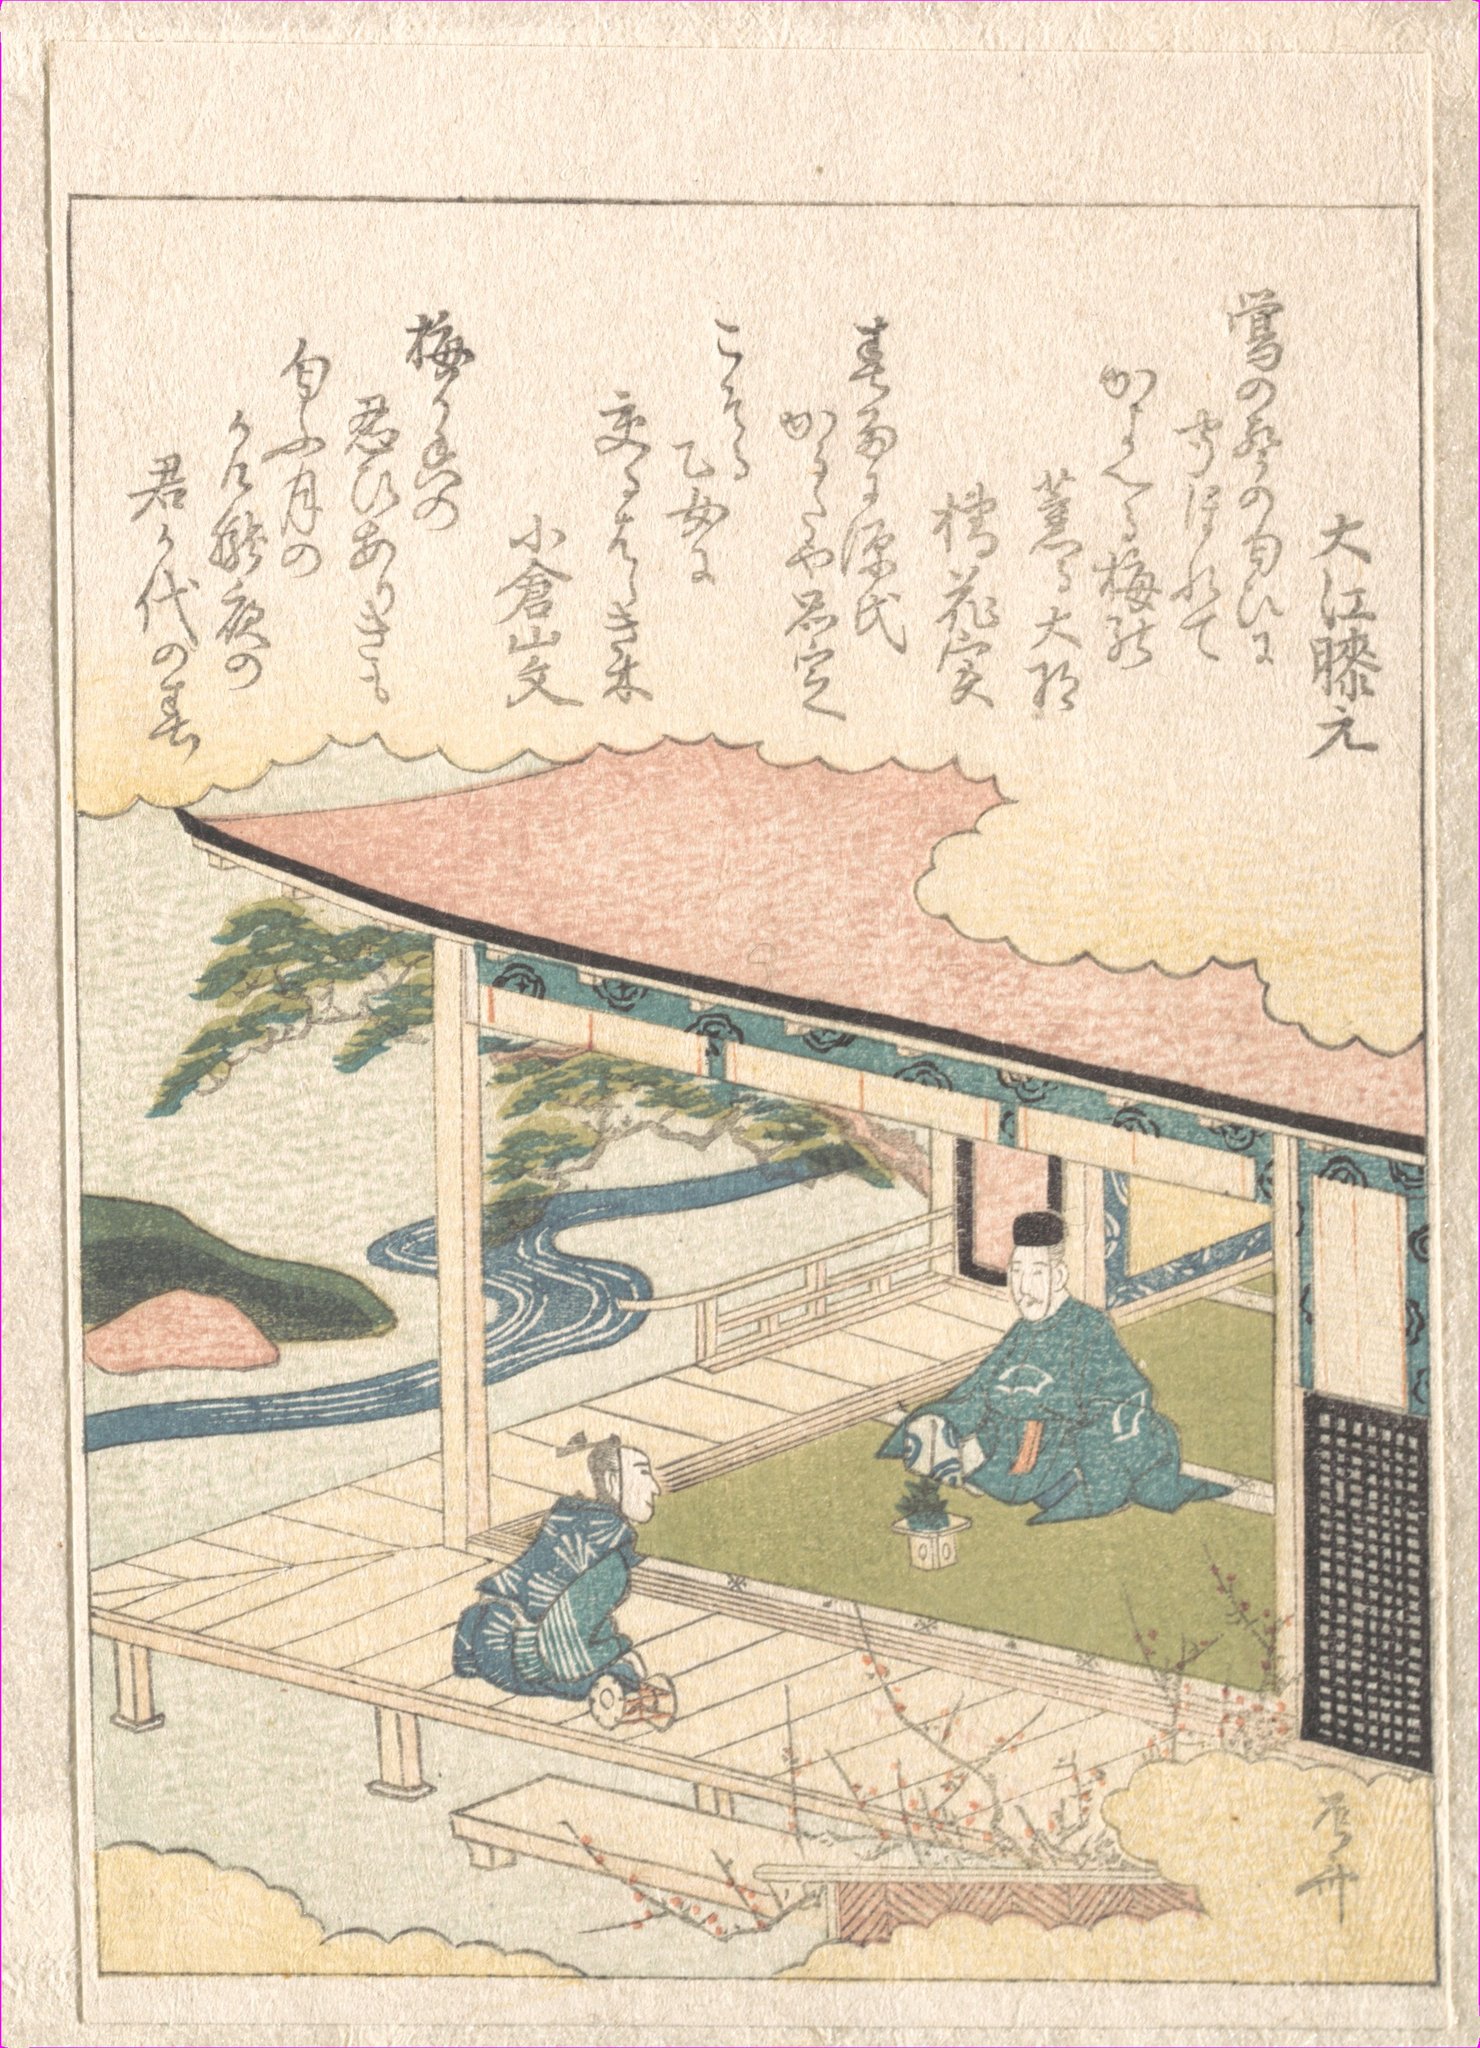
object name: print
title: Samurai Admiring Pine-Tree and Plum Blossoms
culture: japanese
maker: ryūryūkyo shinsai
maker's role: artist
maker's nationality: japanese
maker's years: 1799-1823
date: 1750-1835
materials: ink, paper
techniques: surimono, woodblock print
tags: human figures,houses,samurai